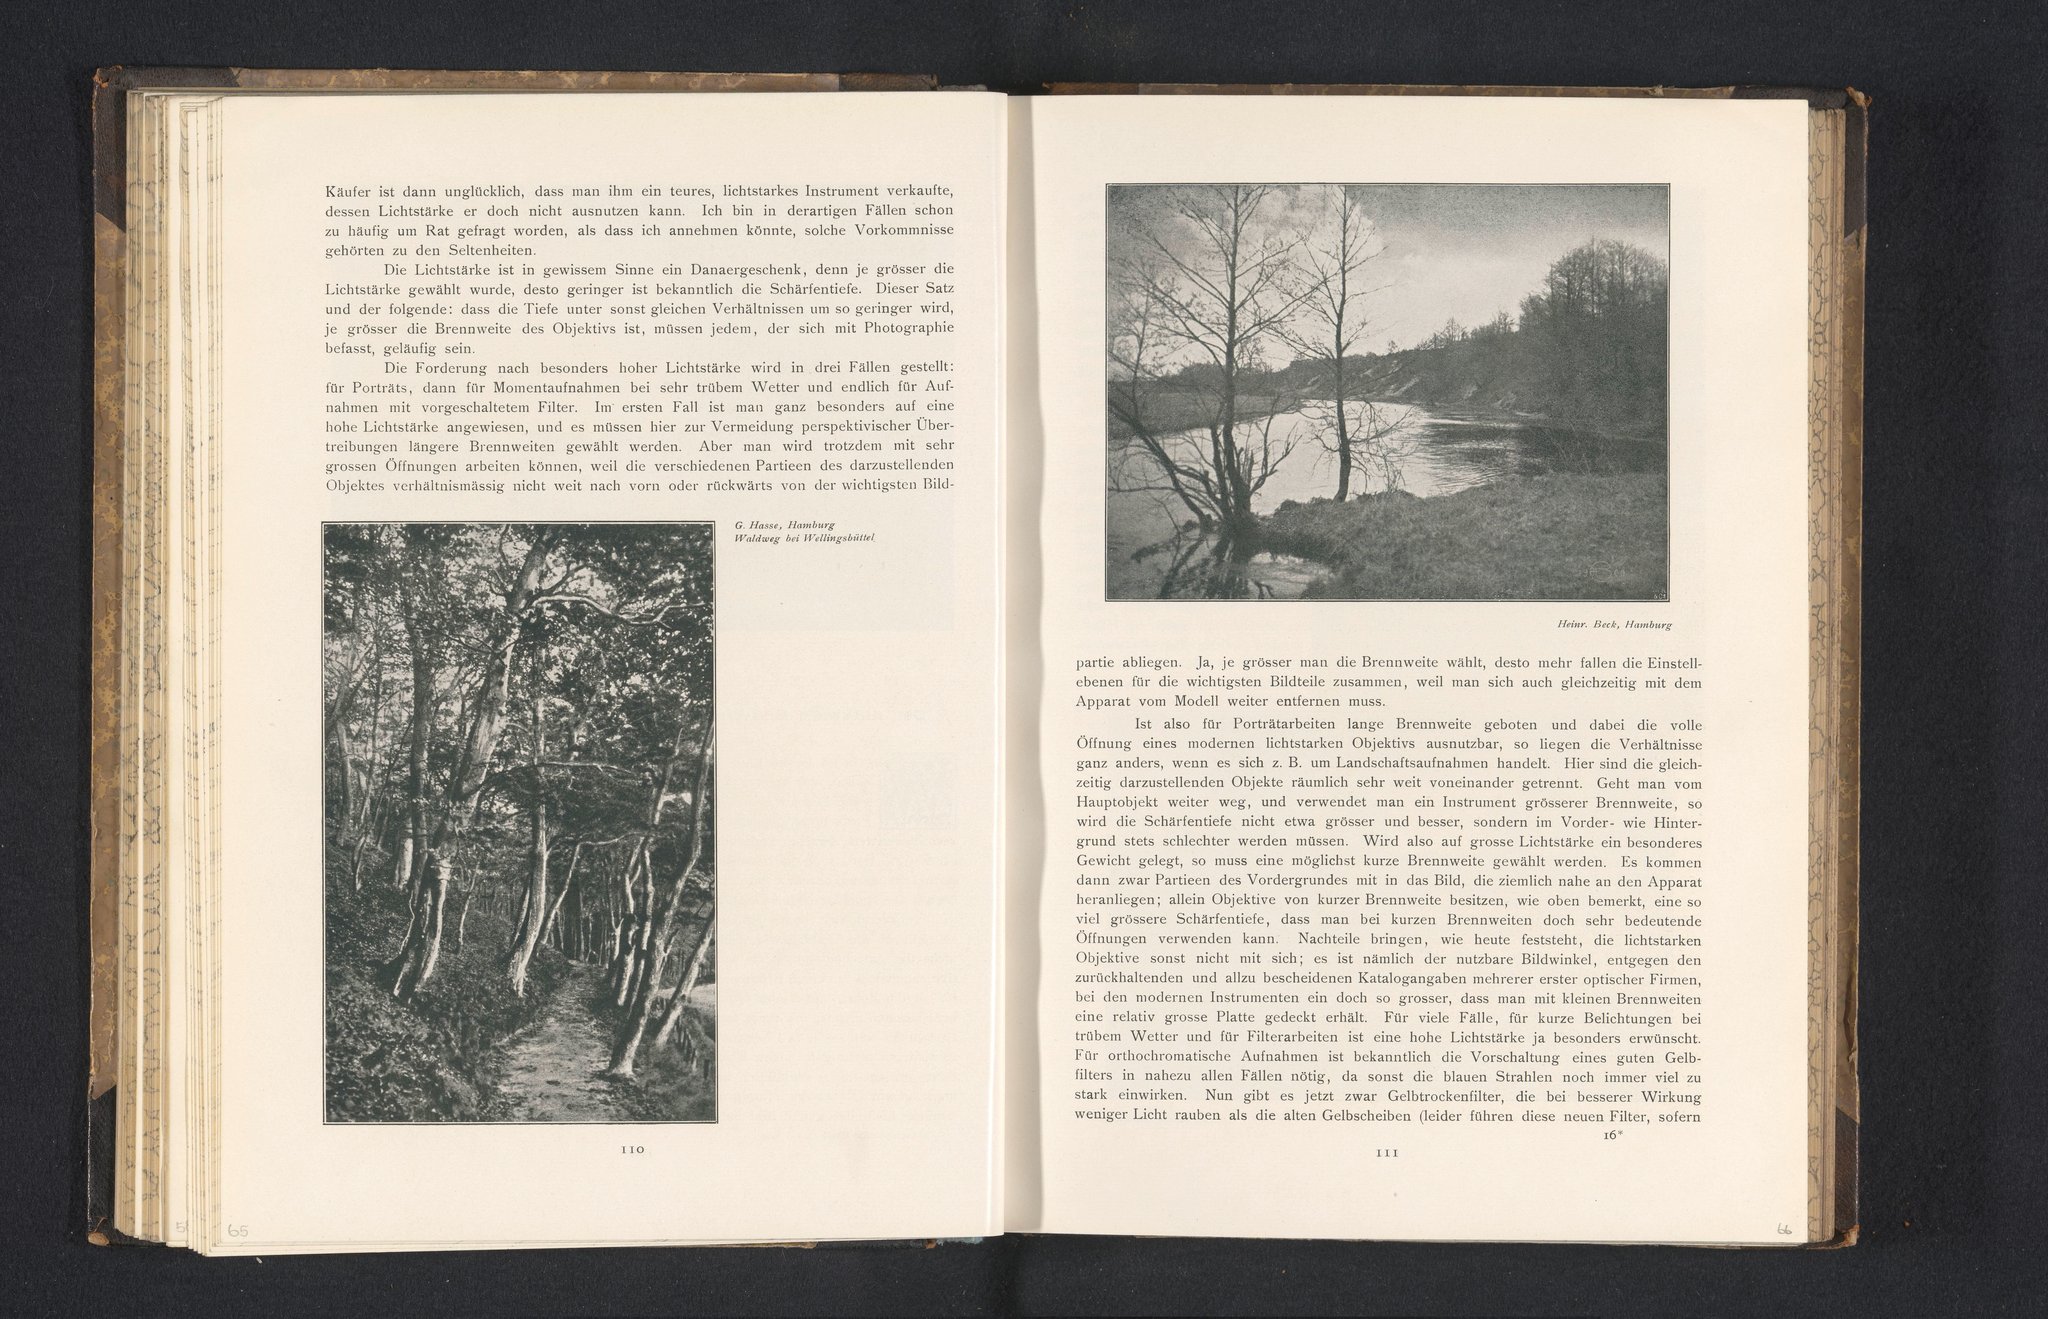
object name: page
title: Waldweg bei Wellingsbüttel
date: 1898-1903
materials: paper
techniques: autotype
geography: hamburg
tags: road, path, forest, wood